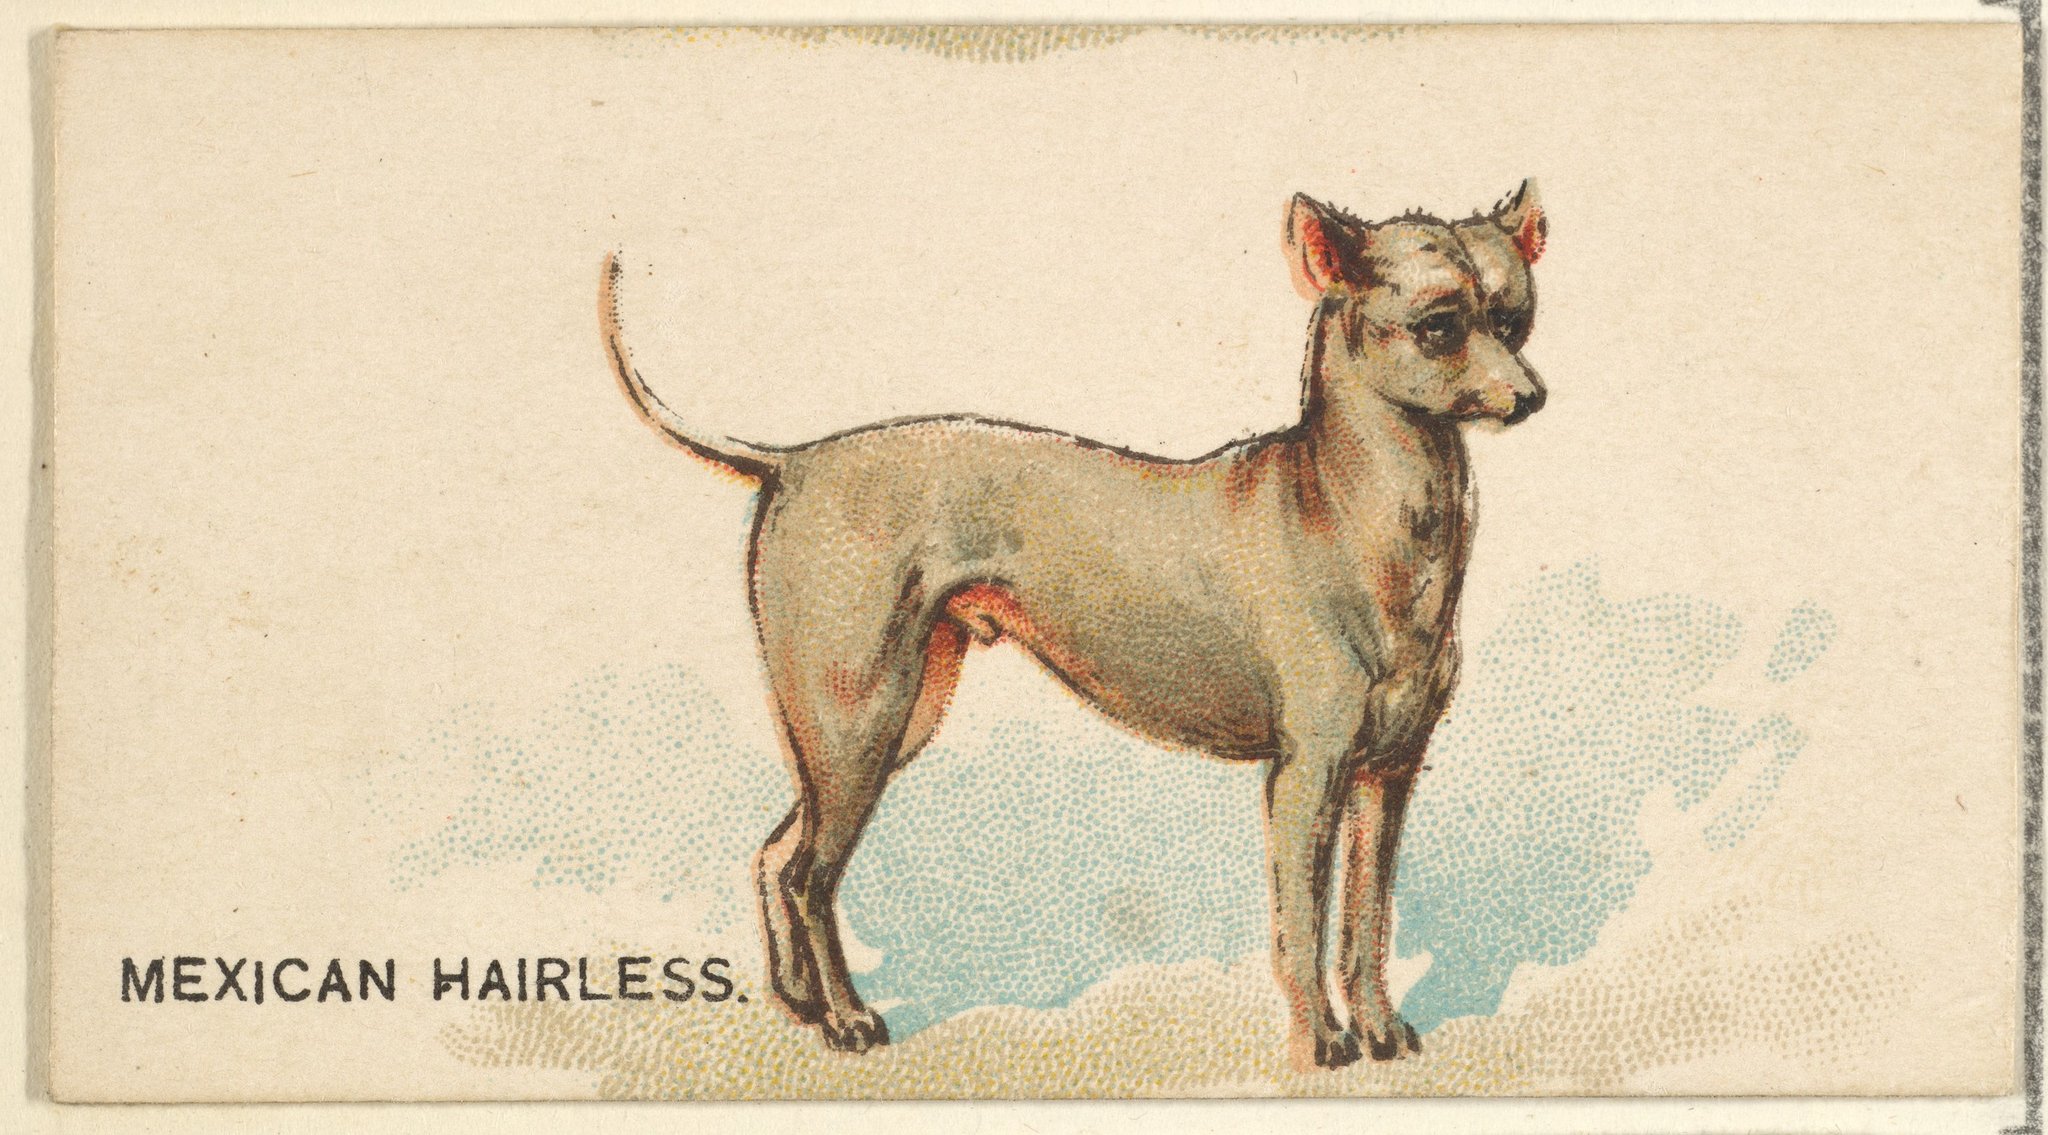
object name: print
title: Mexican Hairless, from the Dogs of the World series for Old Judge Cigarettes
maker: goodwin & company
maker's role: publisher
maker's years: 1850-1950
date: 1890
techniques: color lithograph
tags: dogs